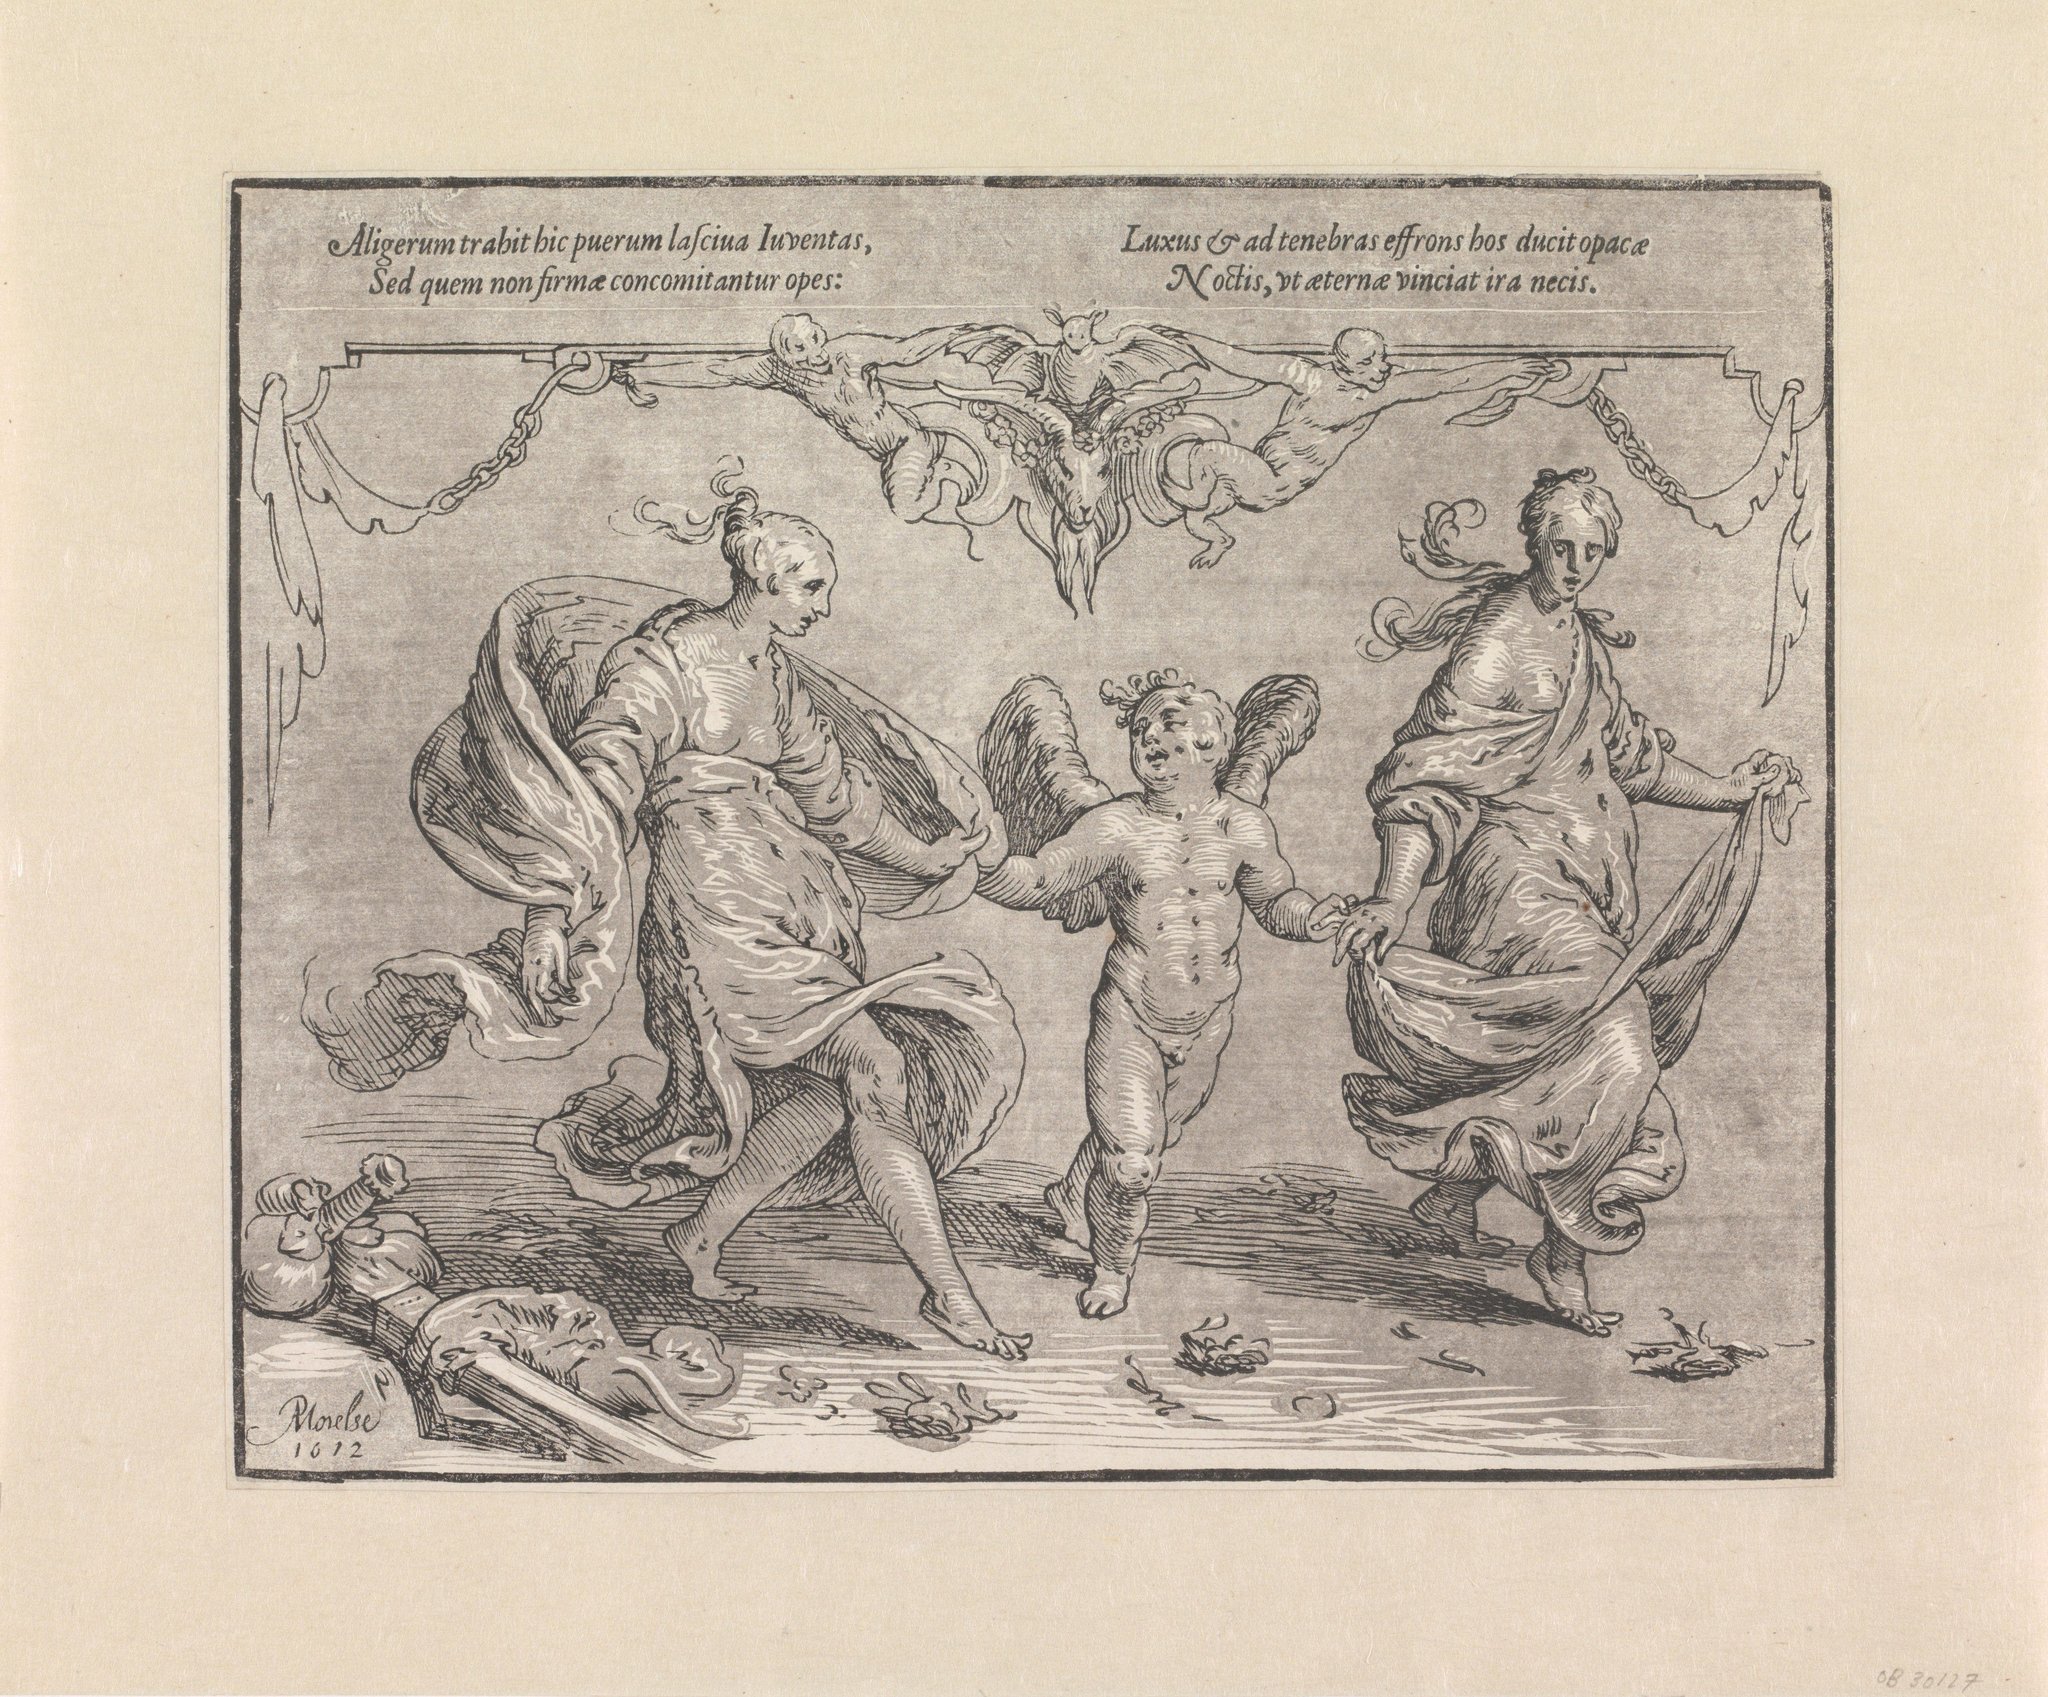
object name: print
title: Cupido danst met twee allegorische vrouwfiguren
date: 1612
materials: paper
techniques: woodcut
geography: netherlands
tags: dancing, (story of) cupid, amor (eros)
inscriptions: collector's mark: Lugt 2228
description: Cupido danst met twee allegorische vrouwfiguren. In de bovenmarge twee kolommen met elk twee regels Latijnse tekst.